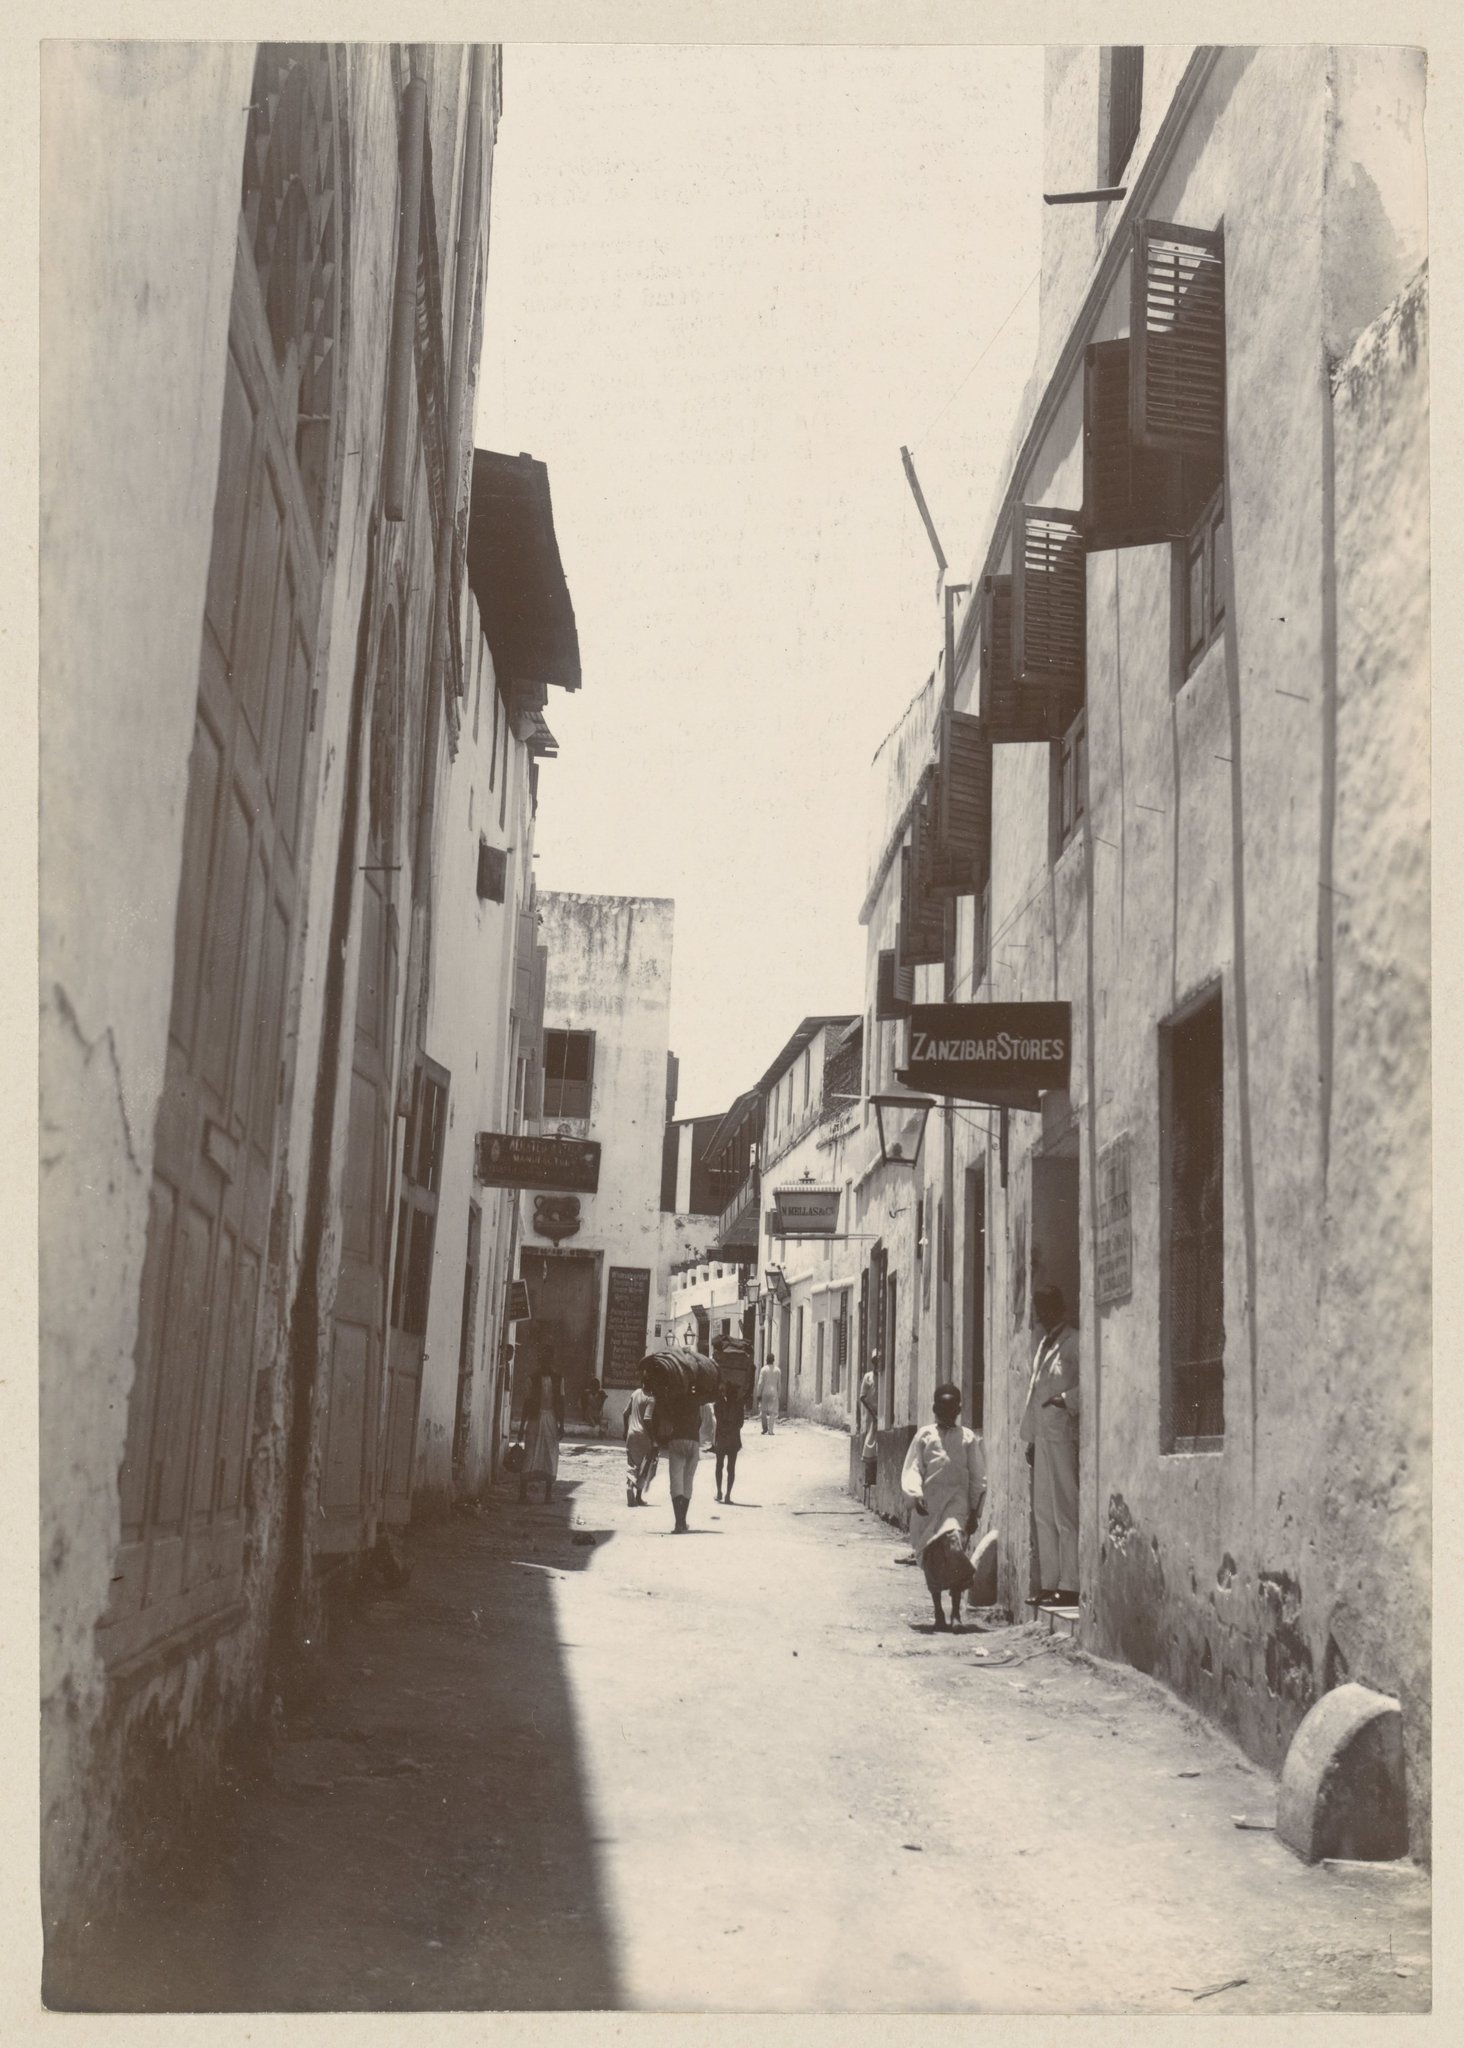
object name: photograph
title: Voorbijgangers in een straat te Zanzibar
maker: Anonymous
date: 1890-1910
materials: cardboard, paper, photographic support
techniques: gelatin silver print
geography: zanzibar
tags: street (+ city(-scape) with figures, staffage)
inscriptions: inscription: ‘Mainroad / Magazine of Mr. Conasjee Dinshaw en Bros. ./ stempel: Zanzibar’